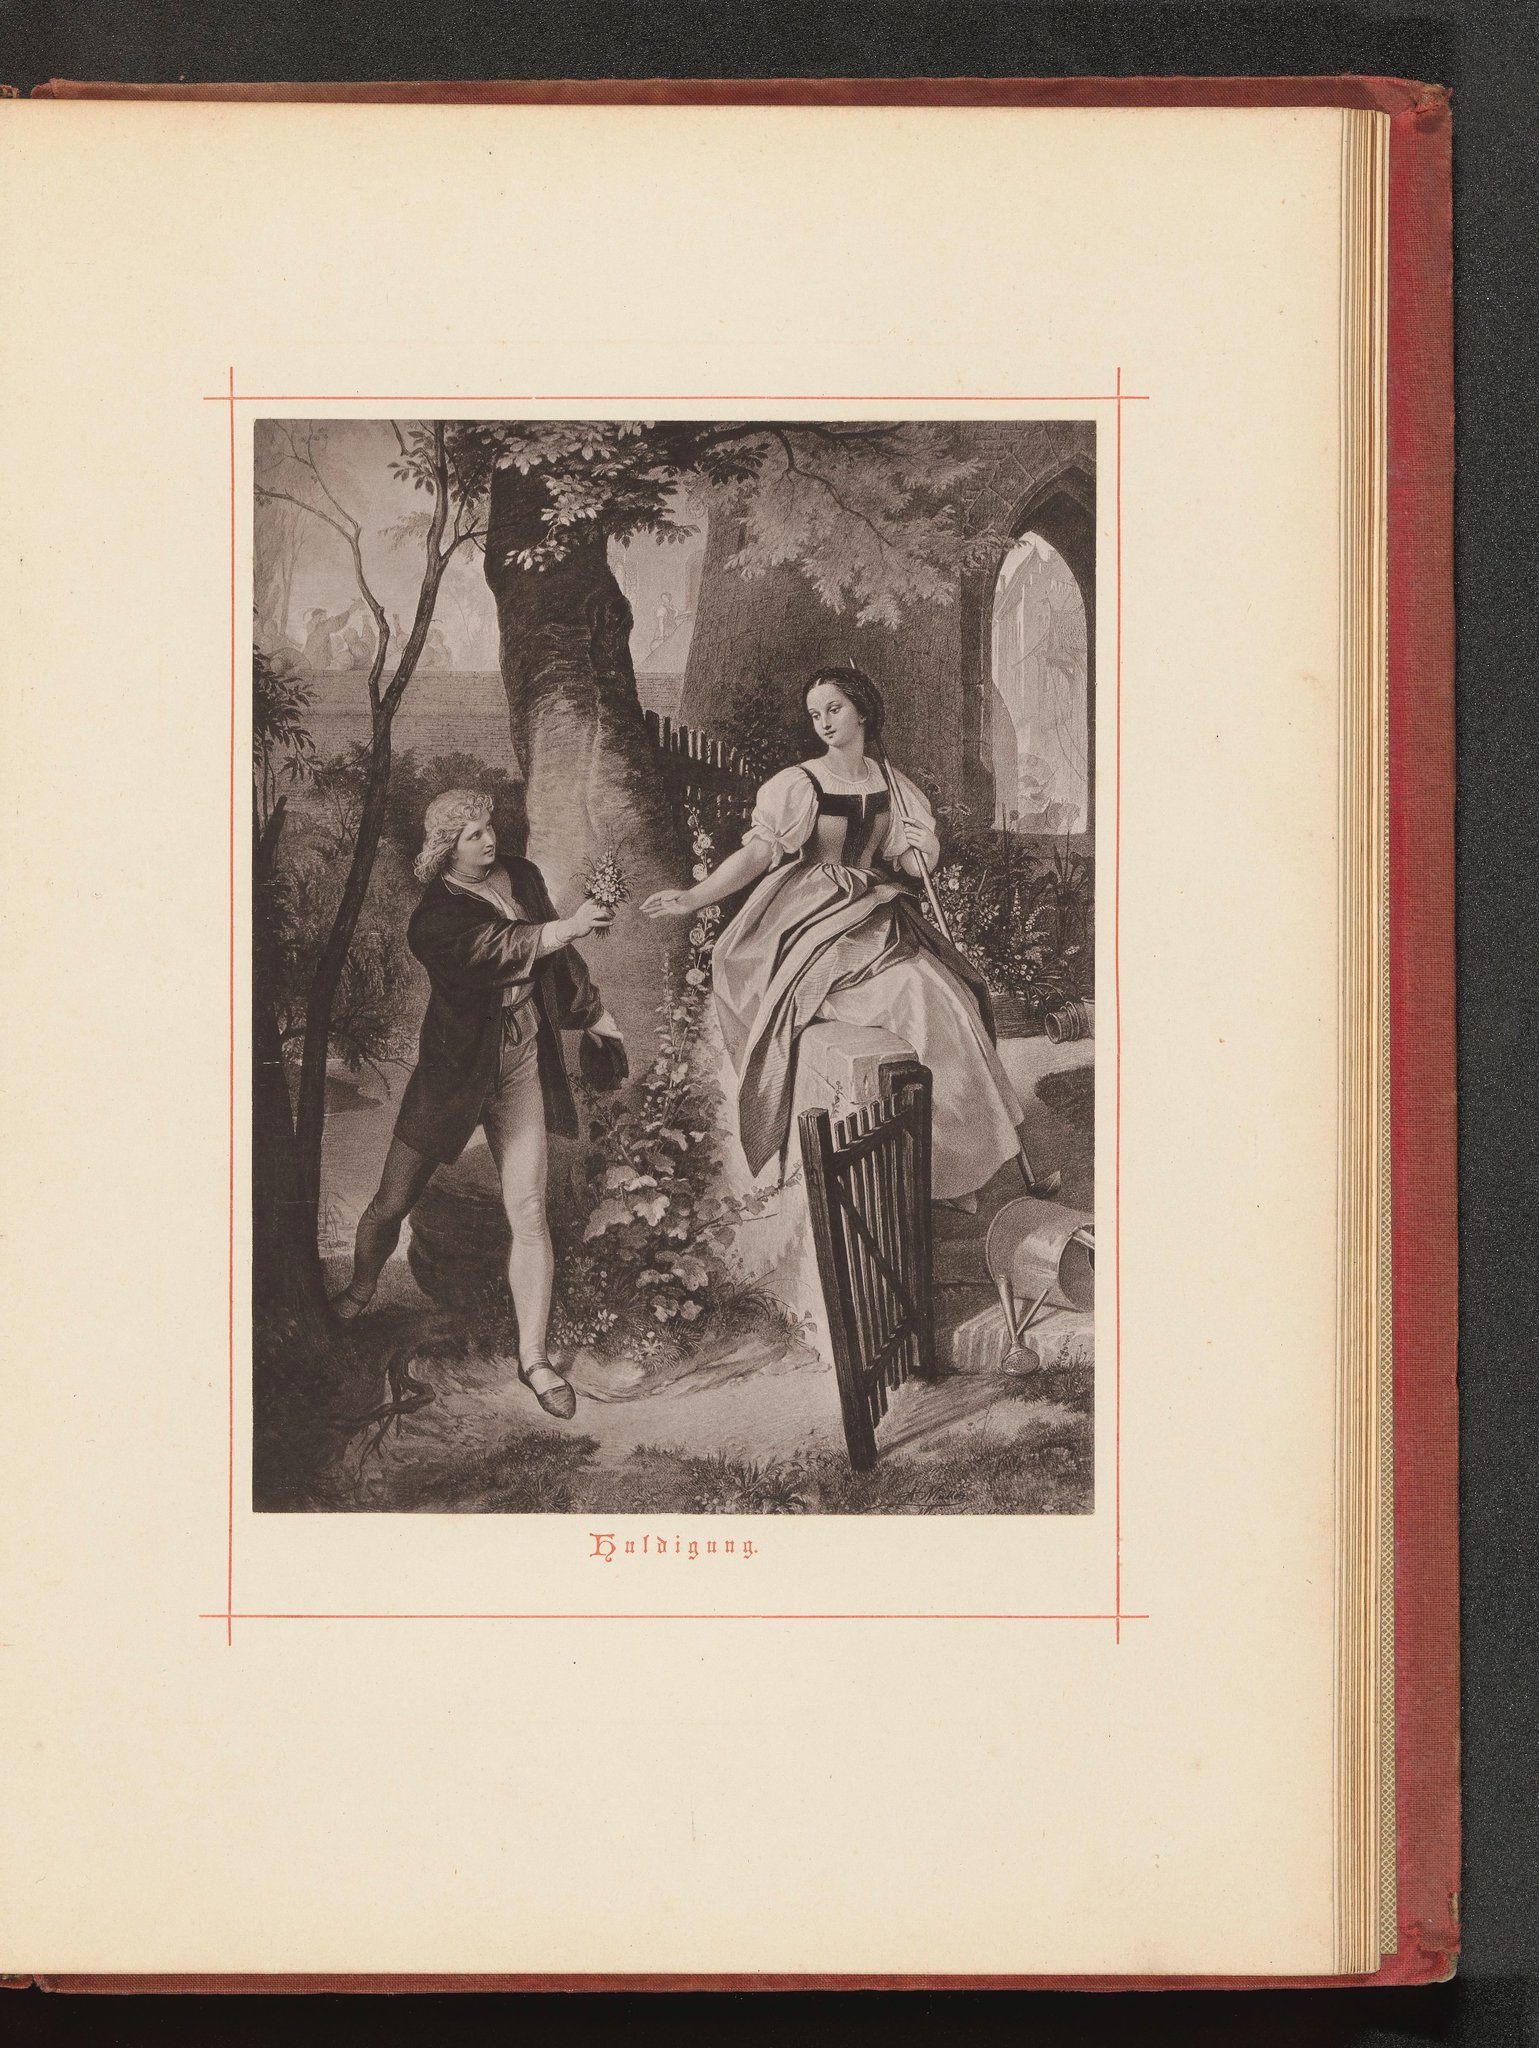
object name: photomechanical print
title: Fotoreproductie van een tekening van een man die een vrouw bloemen geeft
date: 1871-1881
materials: paper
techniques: photograph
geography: munich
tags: cut flowers; nosegay, bunch of flowers, lovers' meeting